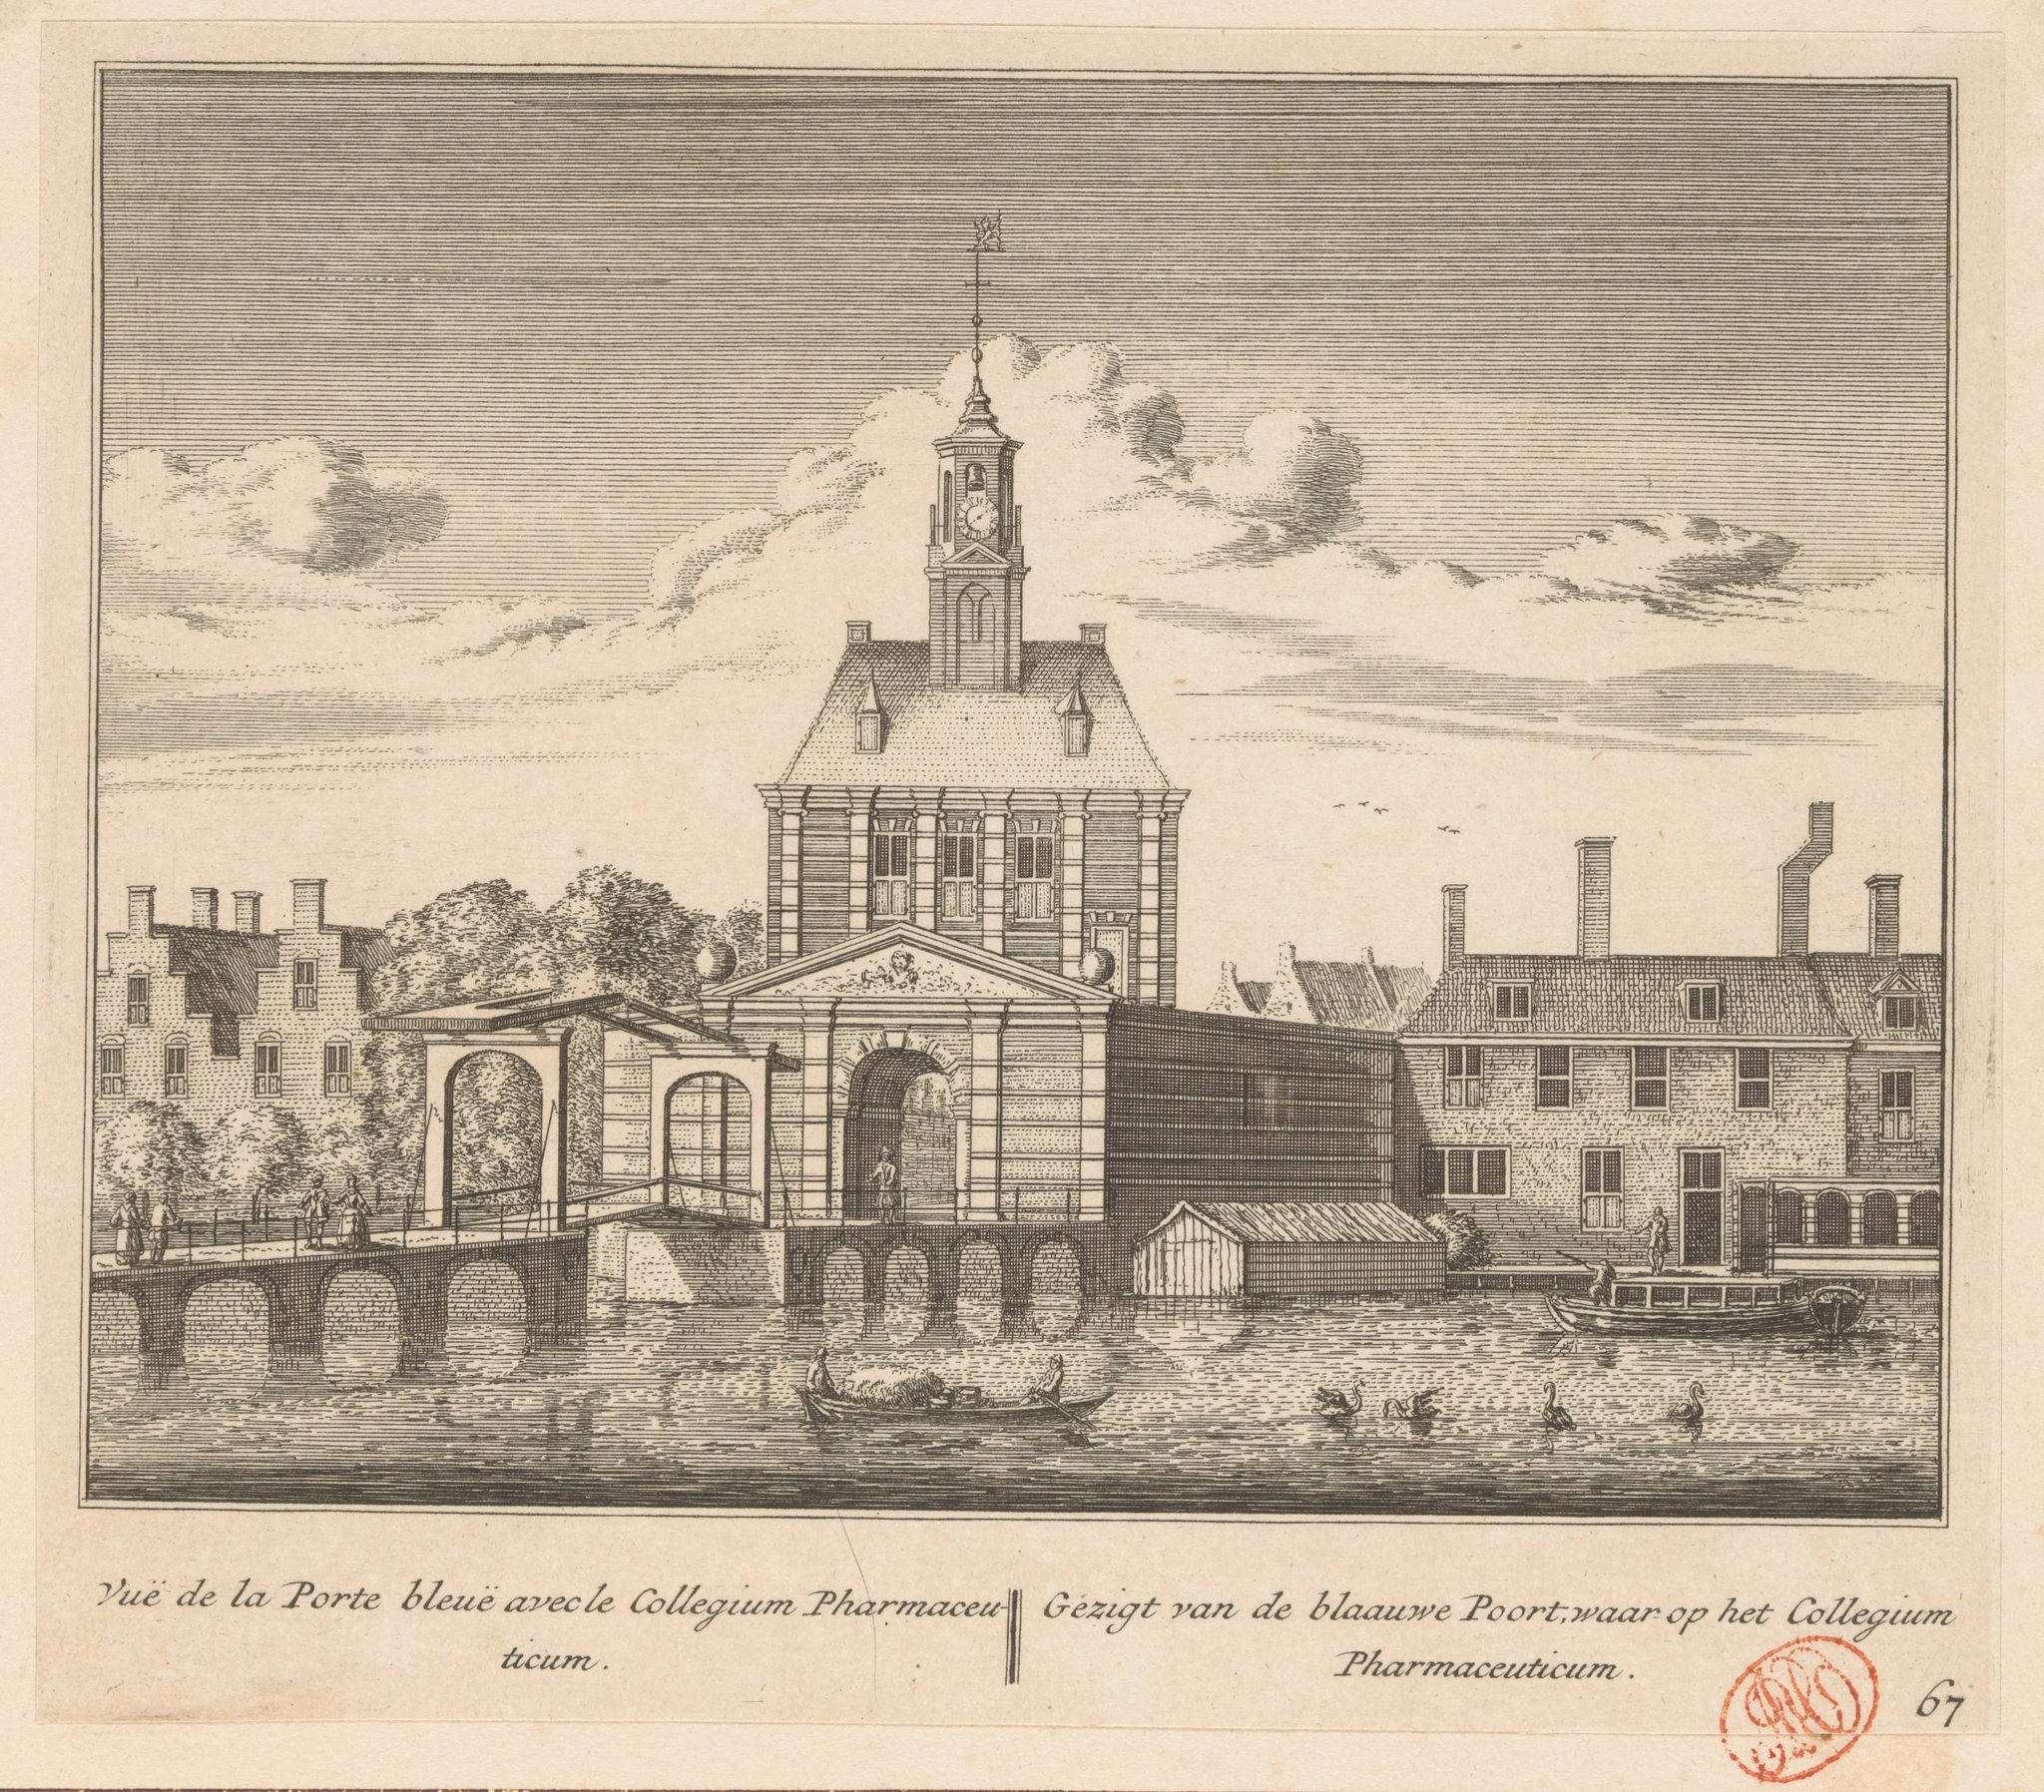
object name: print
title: Gezigt van de blaauwe Poort, waar op het Collegium Pharmaceuticum / Vuë de la Porte bleuë avec le Collegium Pharmaceuticum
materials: paper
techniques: etching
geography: amsterdam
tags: university building, college, city-gate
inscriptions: collector's mark: Lugt 195, collector's mark: Lugt 2228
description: Prent ook gebruikt in: Rademaker, Abraham. Rhynlands fraaiste gezichten; vertonende alle deszelfs lustplaatzen, heeren-huizen en dorpen. Van halfwegen Haarlem en Leyden (…) / Les plus agréables vuës de Rhynland, representant toutes les maisons de plaisance, maisons seigneuriales & villages. Commençant à demilieu Haarlem & Leyden (…). Ansterdam: Leonard Schenk, 1732.